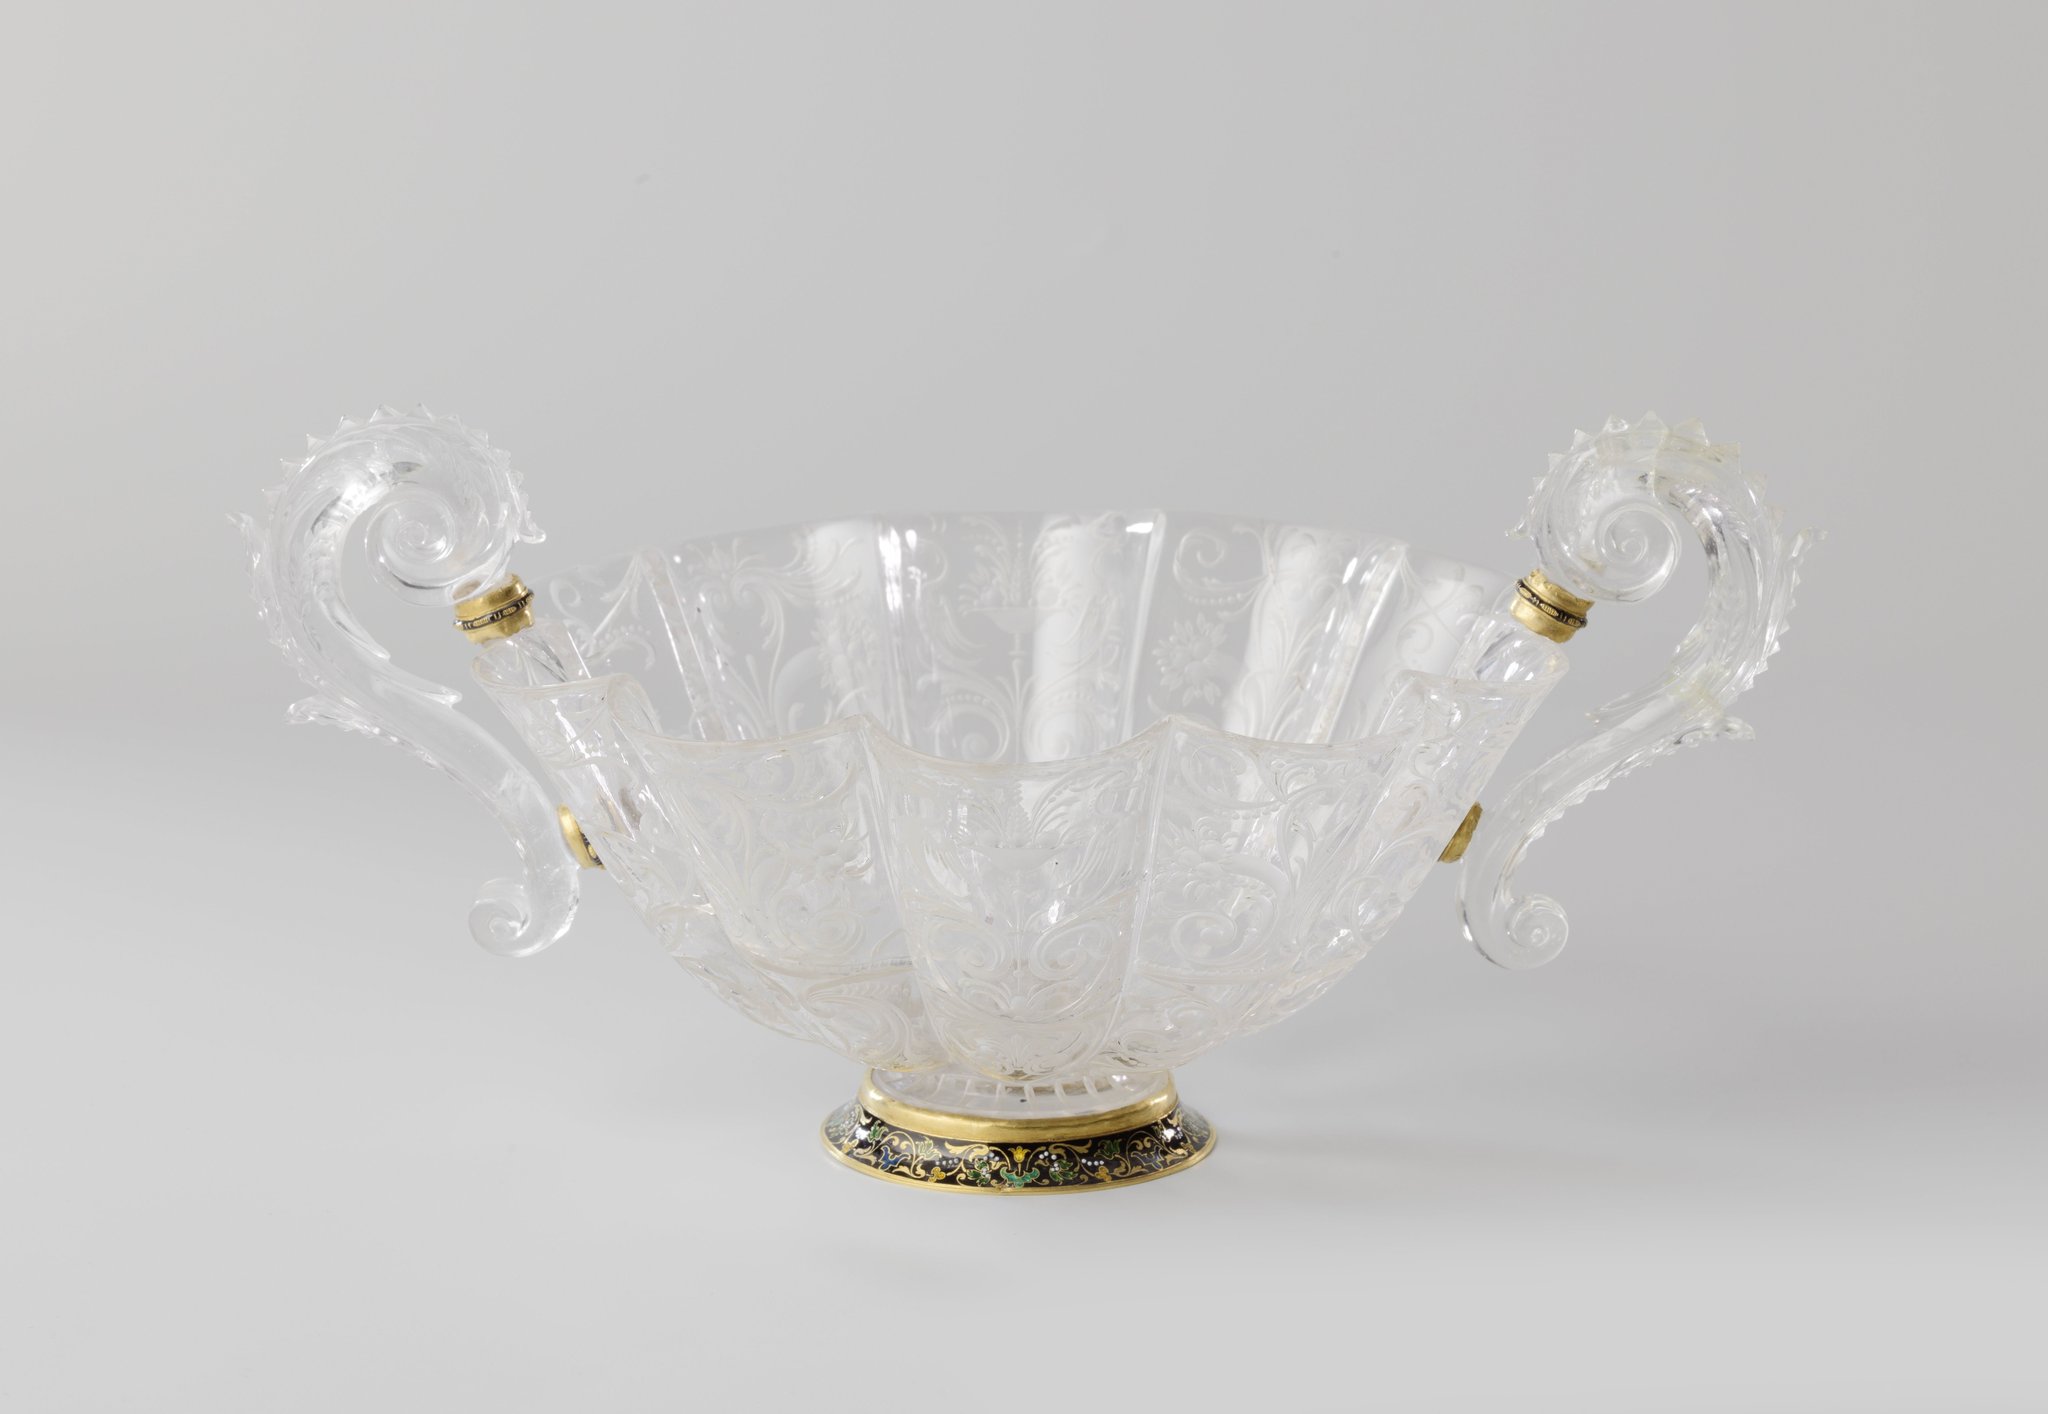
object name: dish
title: Footed dish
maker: Anonymous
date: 1550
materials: gold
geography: milan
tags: ornaments ~ art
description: Tienlobbige, diepe schaal van bergkristal met zwart geëmailleerde, gouden voet. De schaal is versierd met ranken, vrucht-trossen en vogels in slijpwerk. Twee S-vormige kristallen oren.